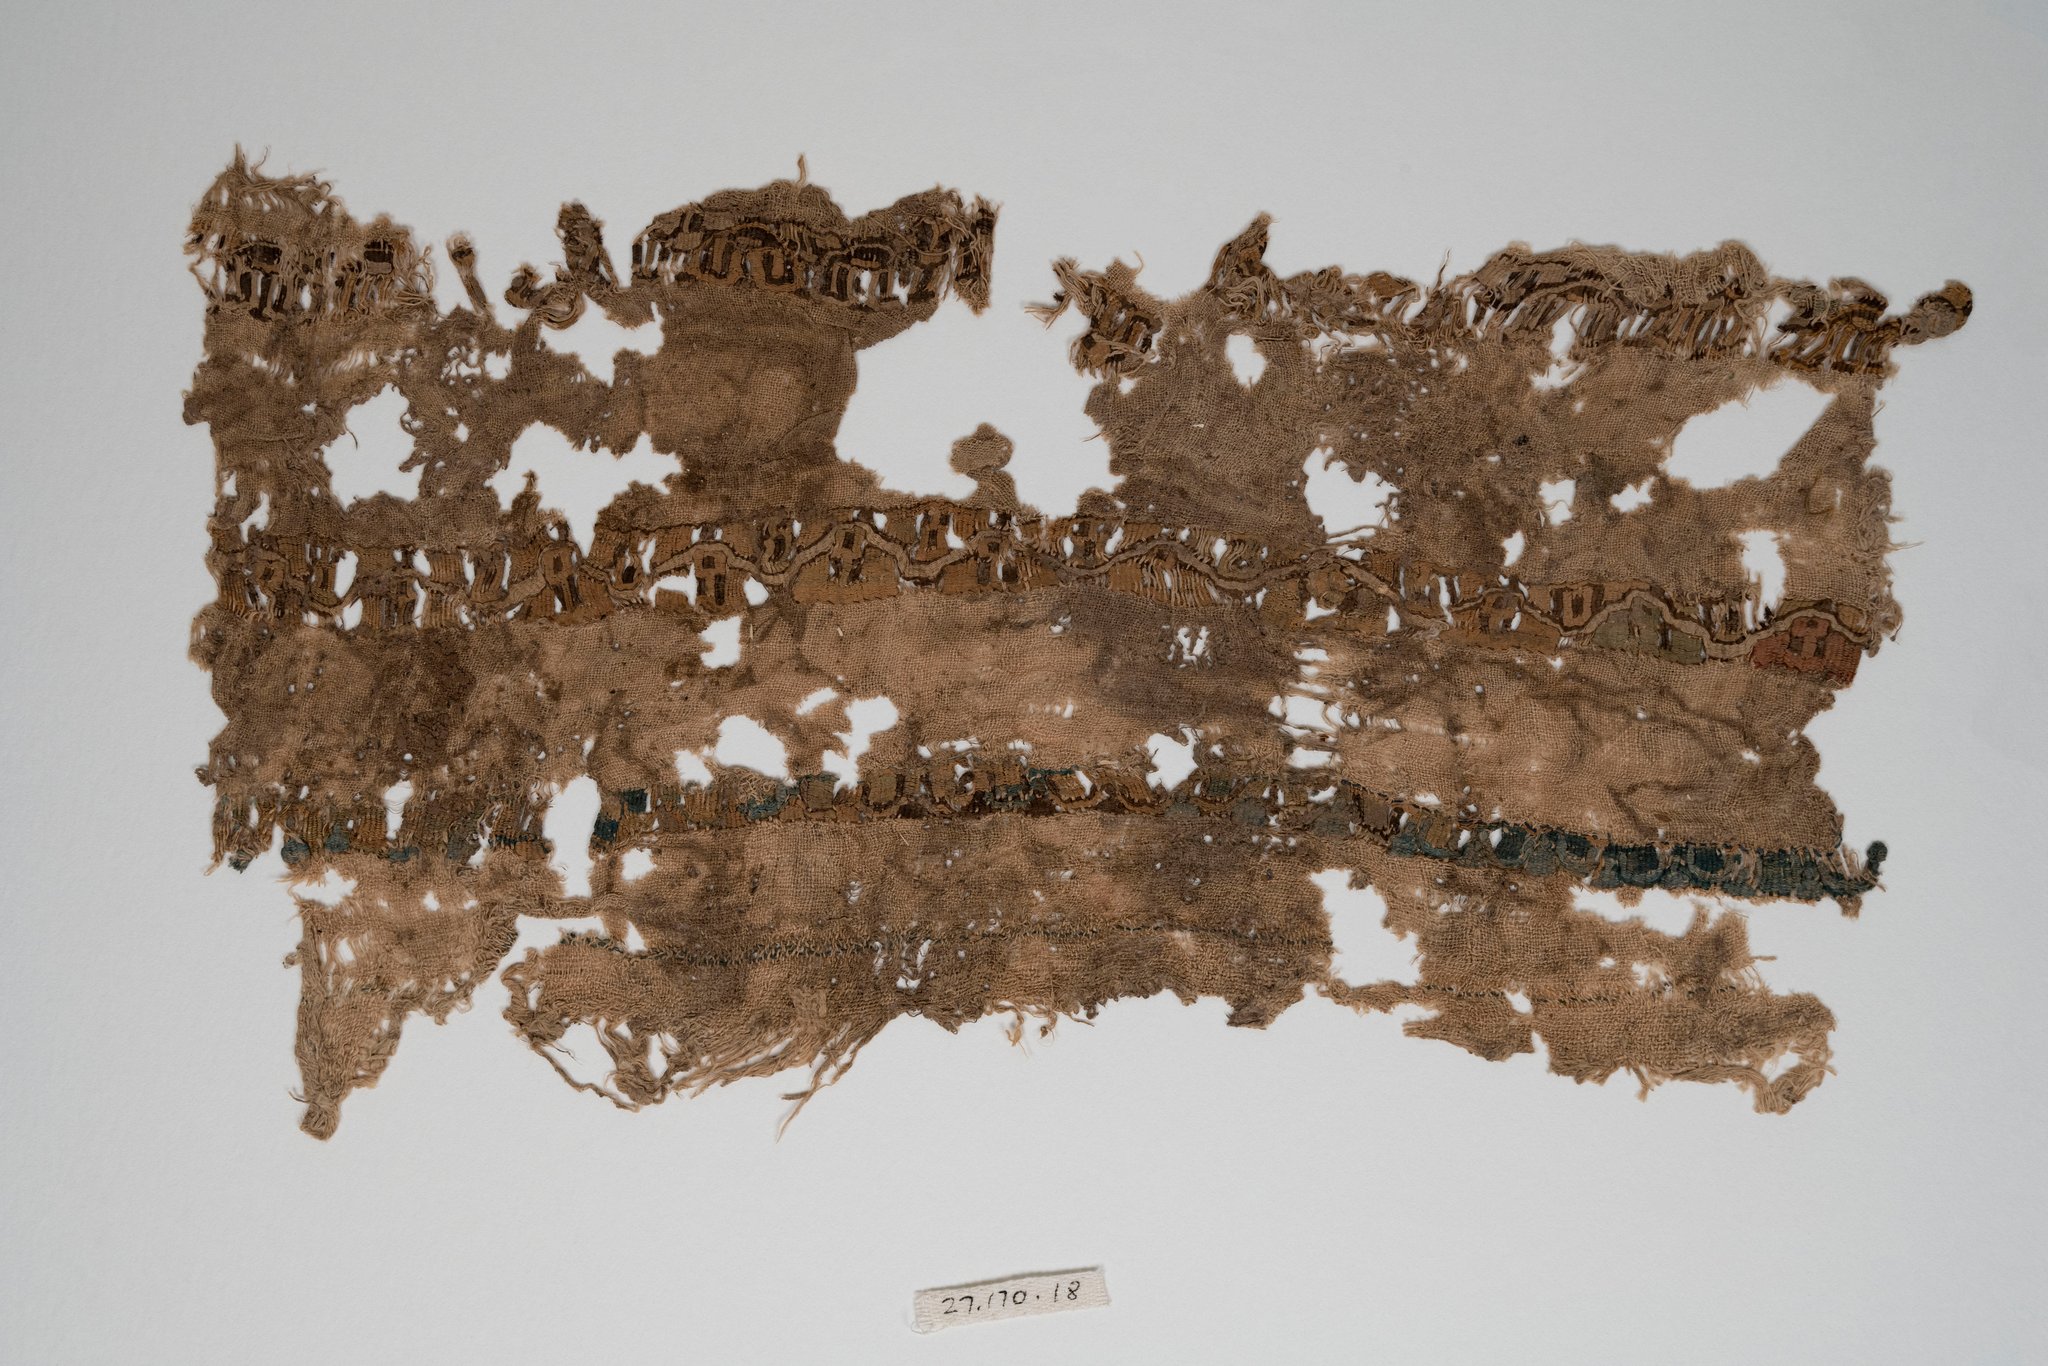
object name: textile fragment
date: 1001-1100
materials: cotton, silk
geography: egypt